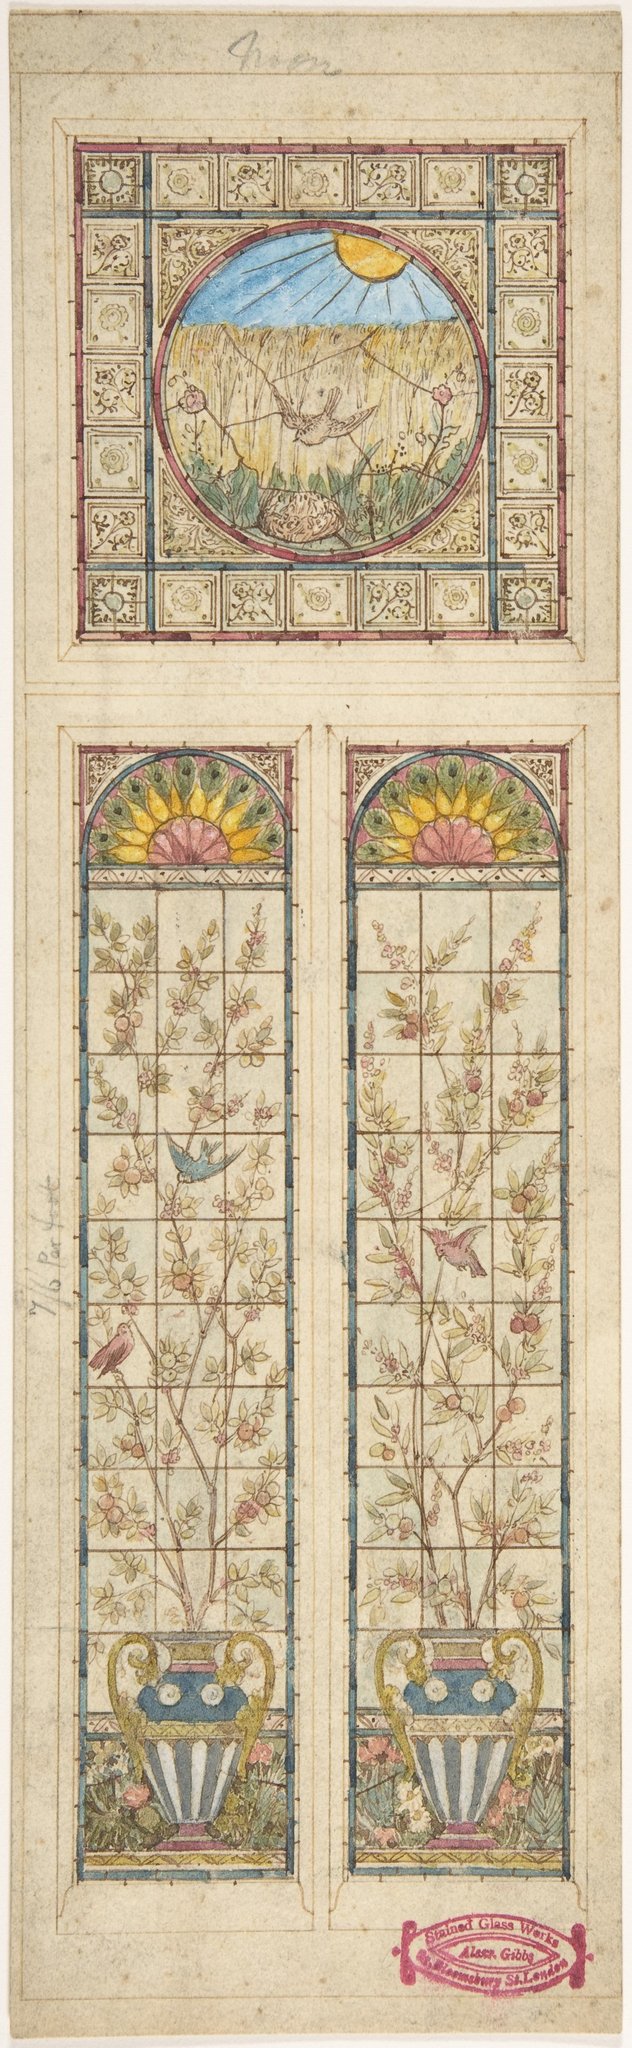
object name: drawing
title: Design for a stained glass window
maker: alexander gibbs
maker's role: artist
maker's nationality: british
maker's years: 1832-1886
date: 1866-1892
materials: graphite, ink, watercolor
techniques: pen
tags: birds,windows,plants